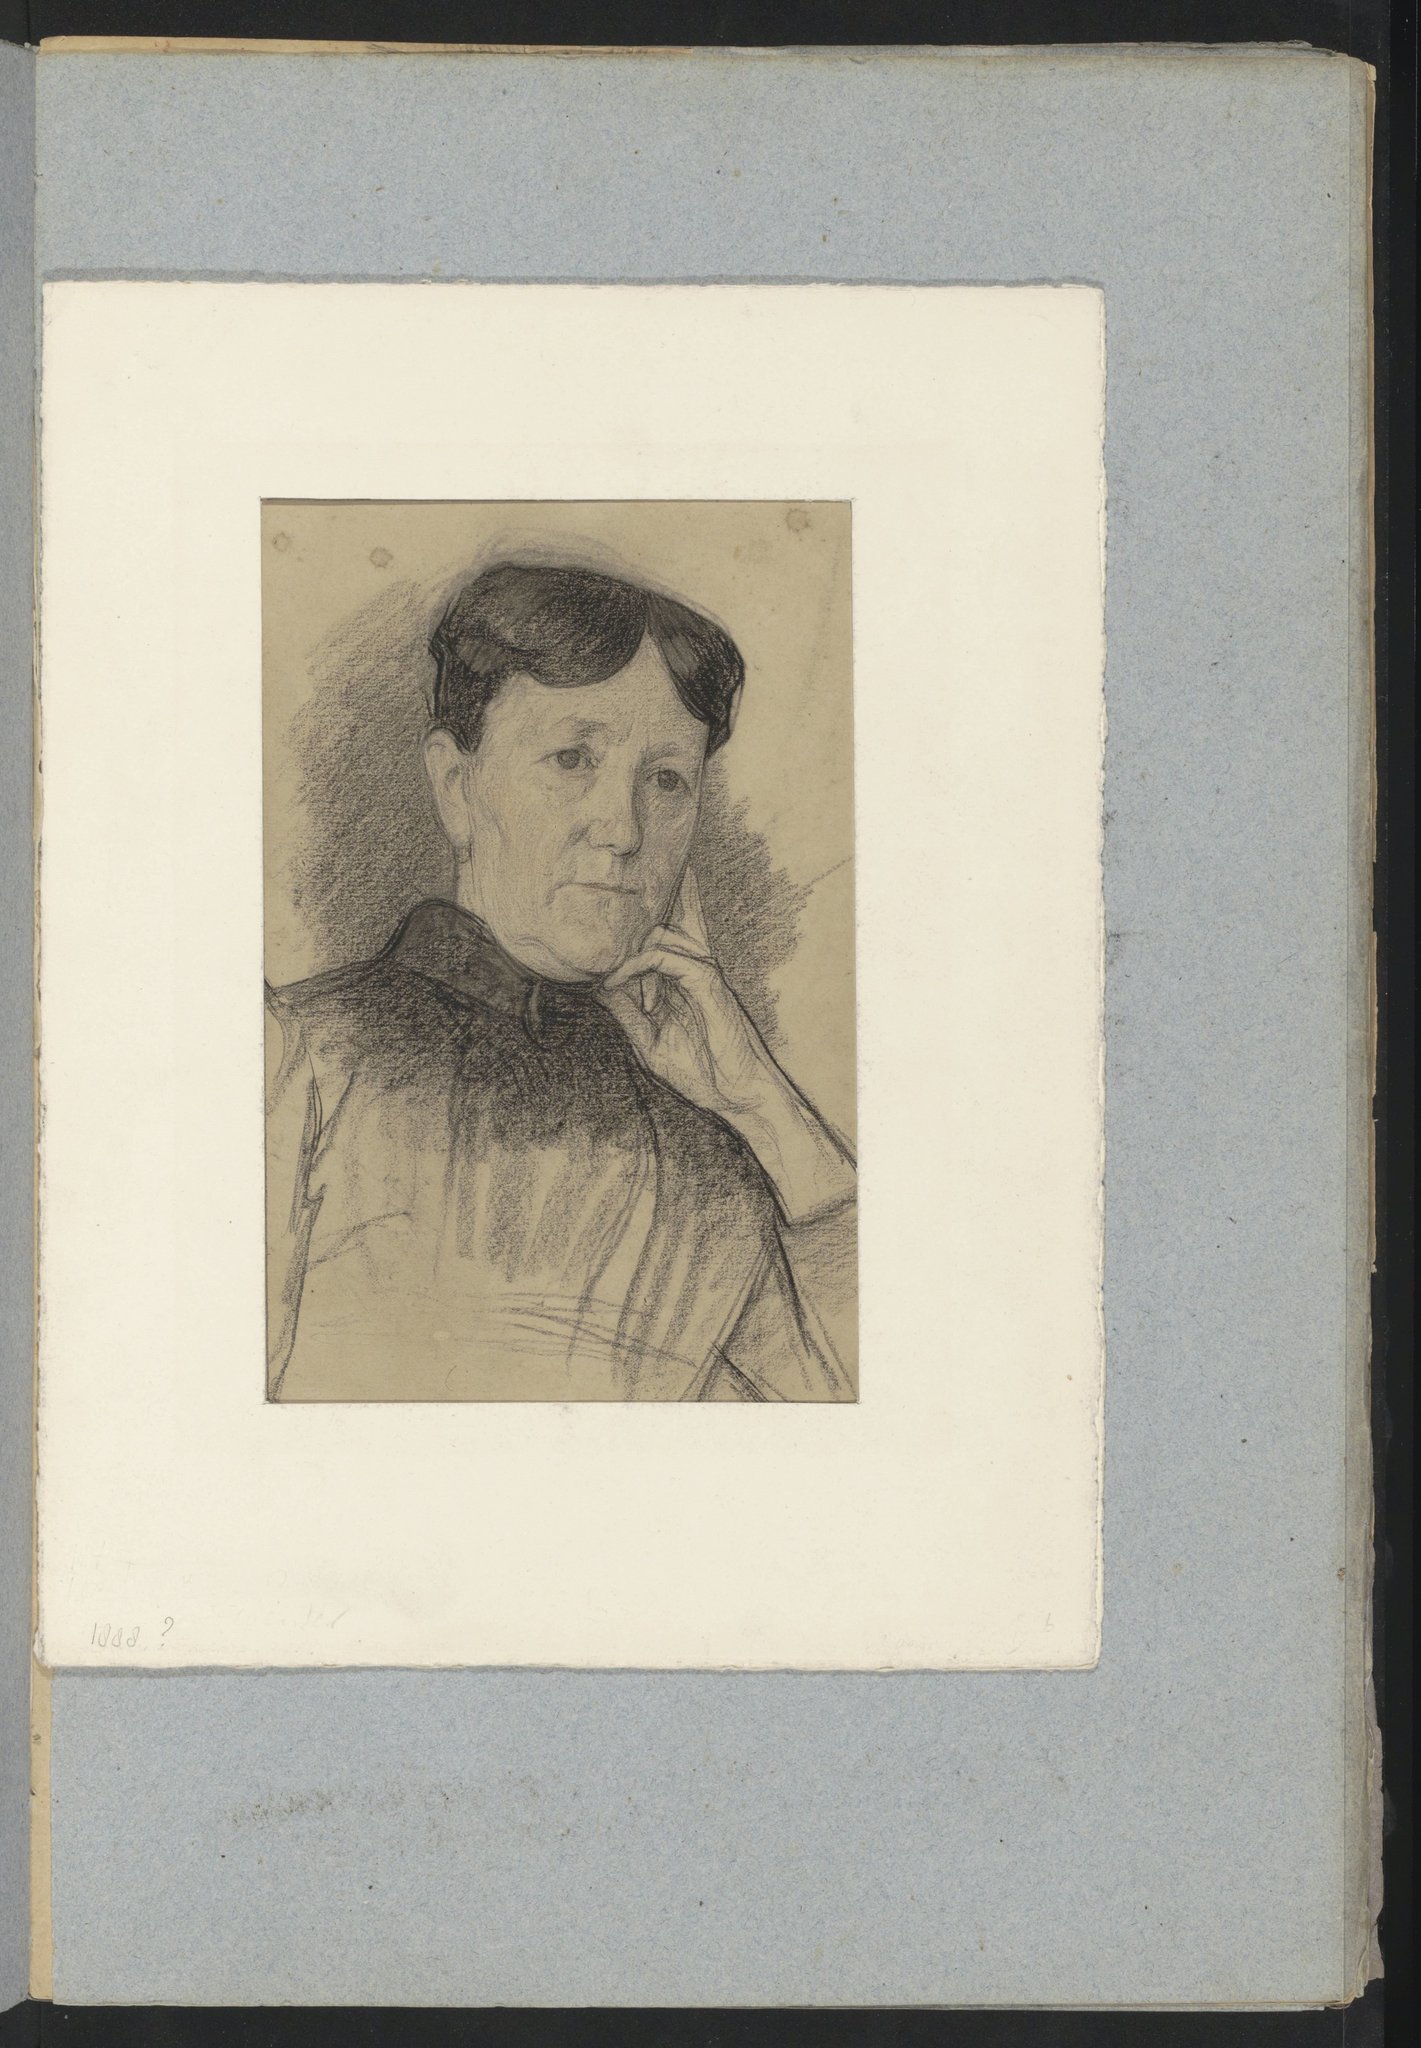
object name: sketchbook leaf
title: Portret van een vrouw, de kin rustend tegen de linkerhand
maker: jan veth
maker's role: designer, draughtsman, painter, print maker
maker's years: 1864-1925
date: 1874-1925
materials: cardboard, chalk, paper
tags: adult woman, hand(s) bent towards the head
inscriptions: date and inscription: ‘1888?/ Cor Moll?’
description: Losse tekening in passe-partout tussen blad 5 en 6 uit een schetsboek met 42 bladen.